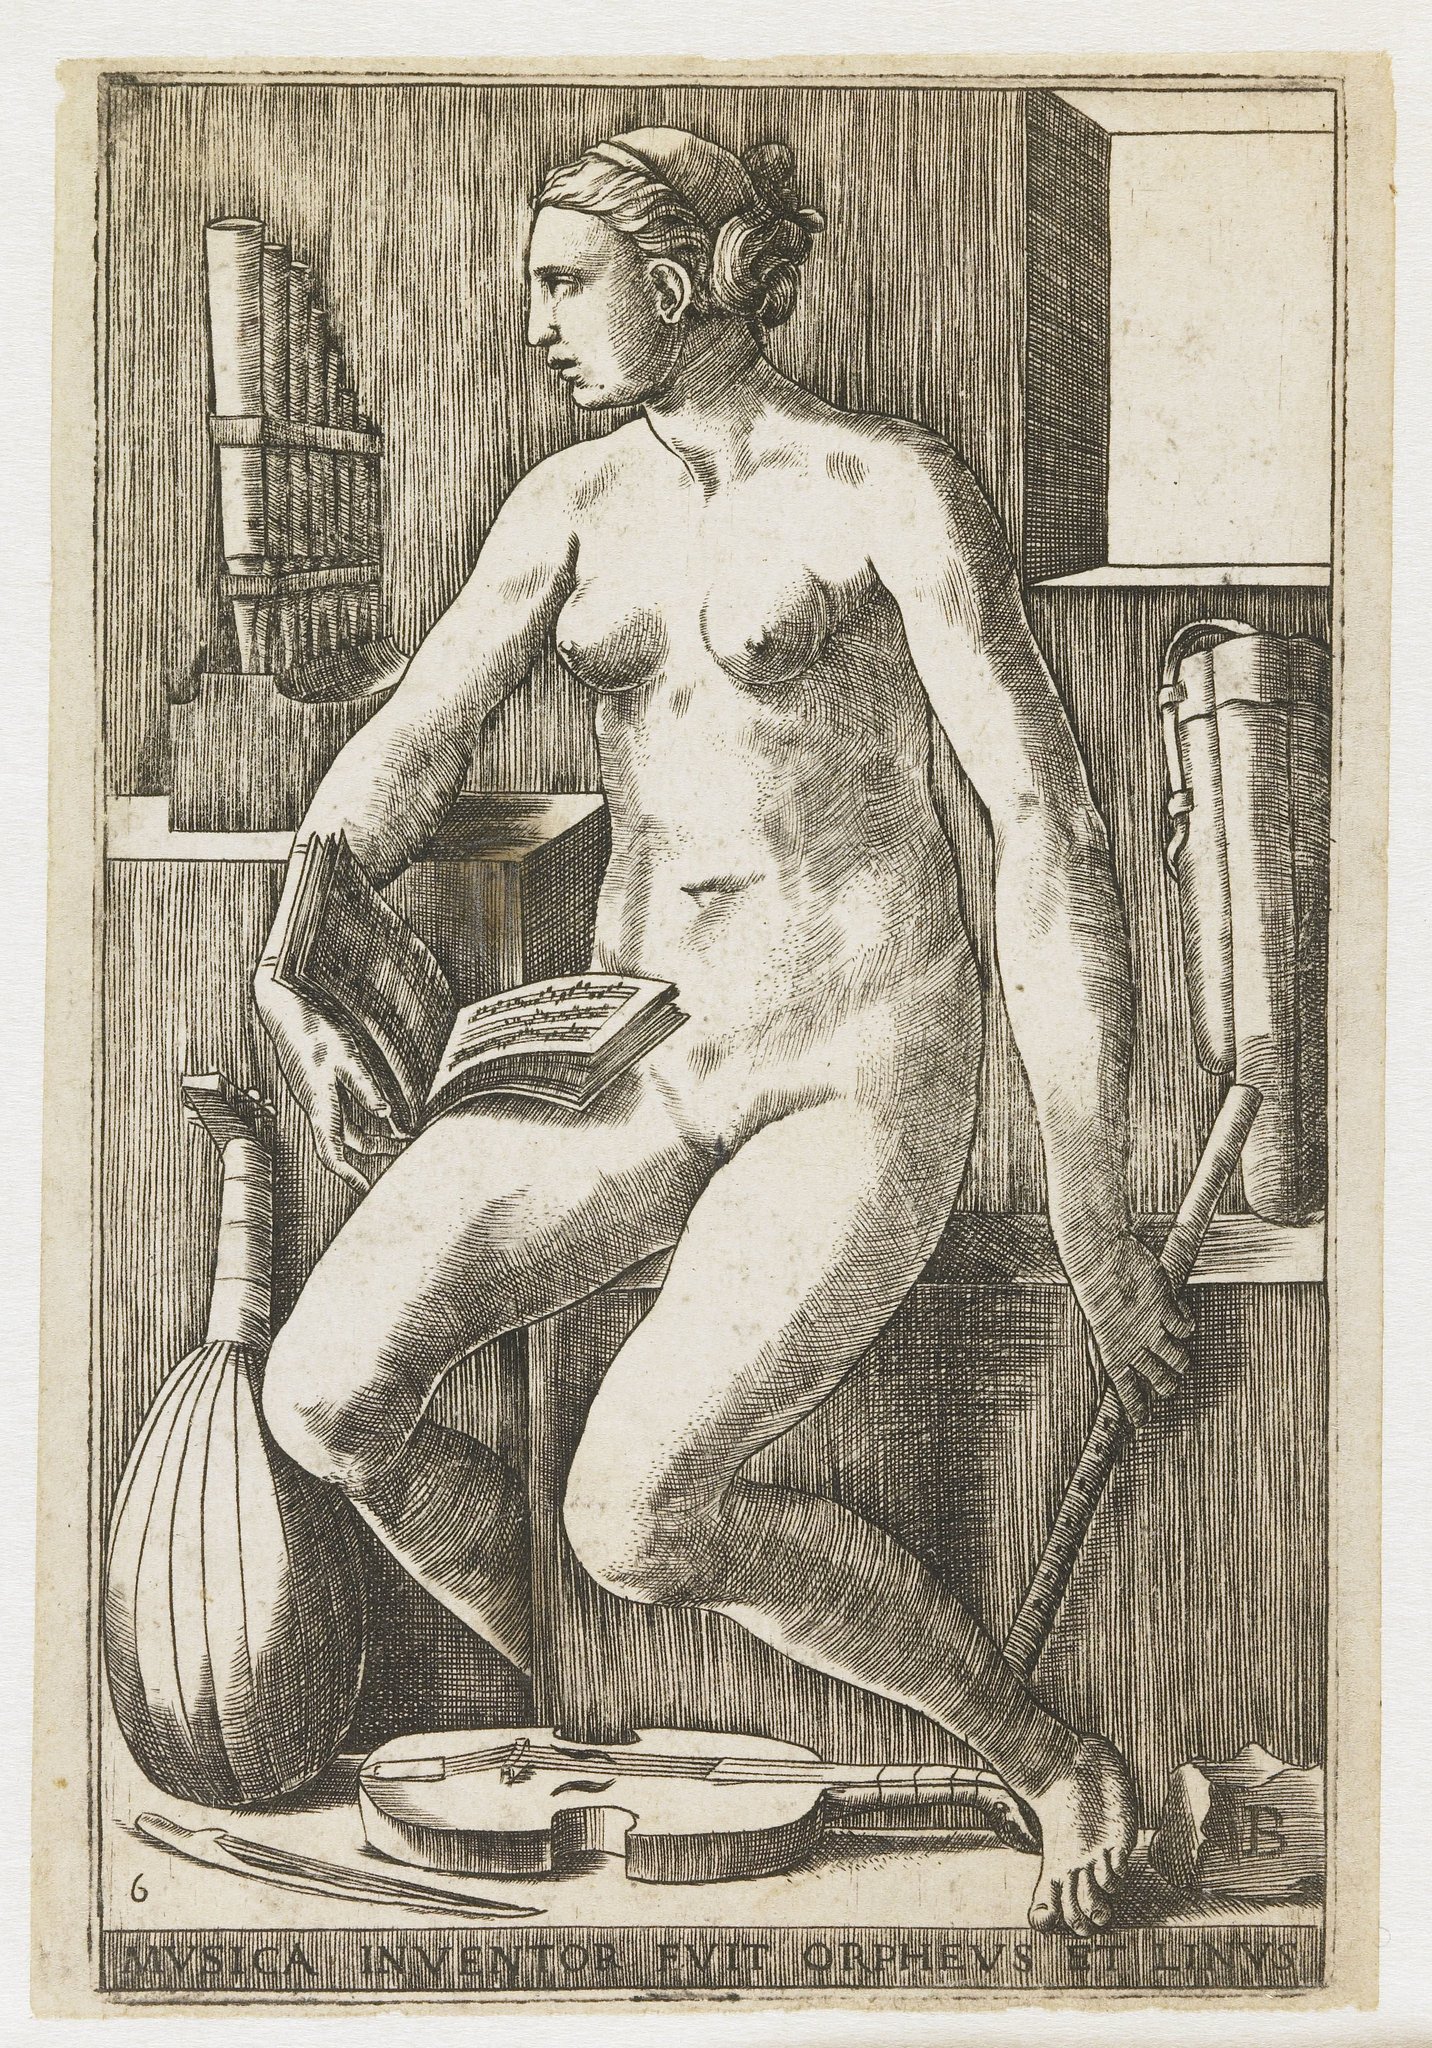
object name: print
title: Musica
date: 1544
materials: paper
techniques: engraving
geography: italy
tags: the liberal arts, 'artes liberales', 'musica' (~ quadrivium); 'musica' (ripa), violin, fiddle, organ, printed edition of musical score, lute, and special forms of lute, e.g.: theorbo, flute, aulos, tibia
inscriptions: collector's mark: Lugt 2760, collector's mark: Lugt 2228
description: Personificatie van de muziek (Musica), een naakte vrouw, zittend, naar links, met fluit en muziekboekje in de handen. Op de grond liggen verschillende snaarinstrumenten (luit, viool); naast haar een tafelorgeltje.